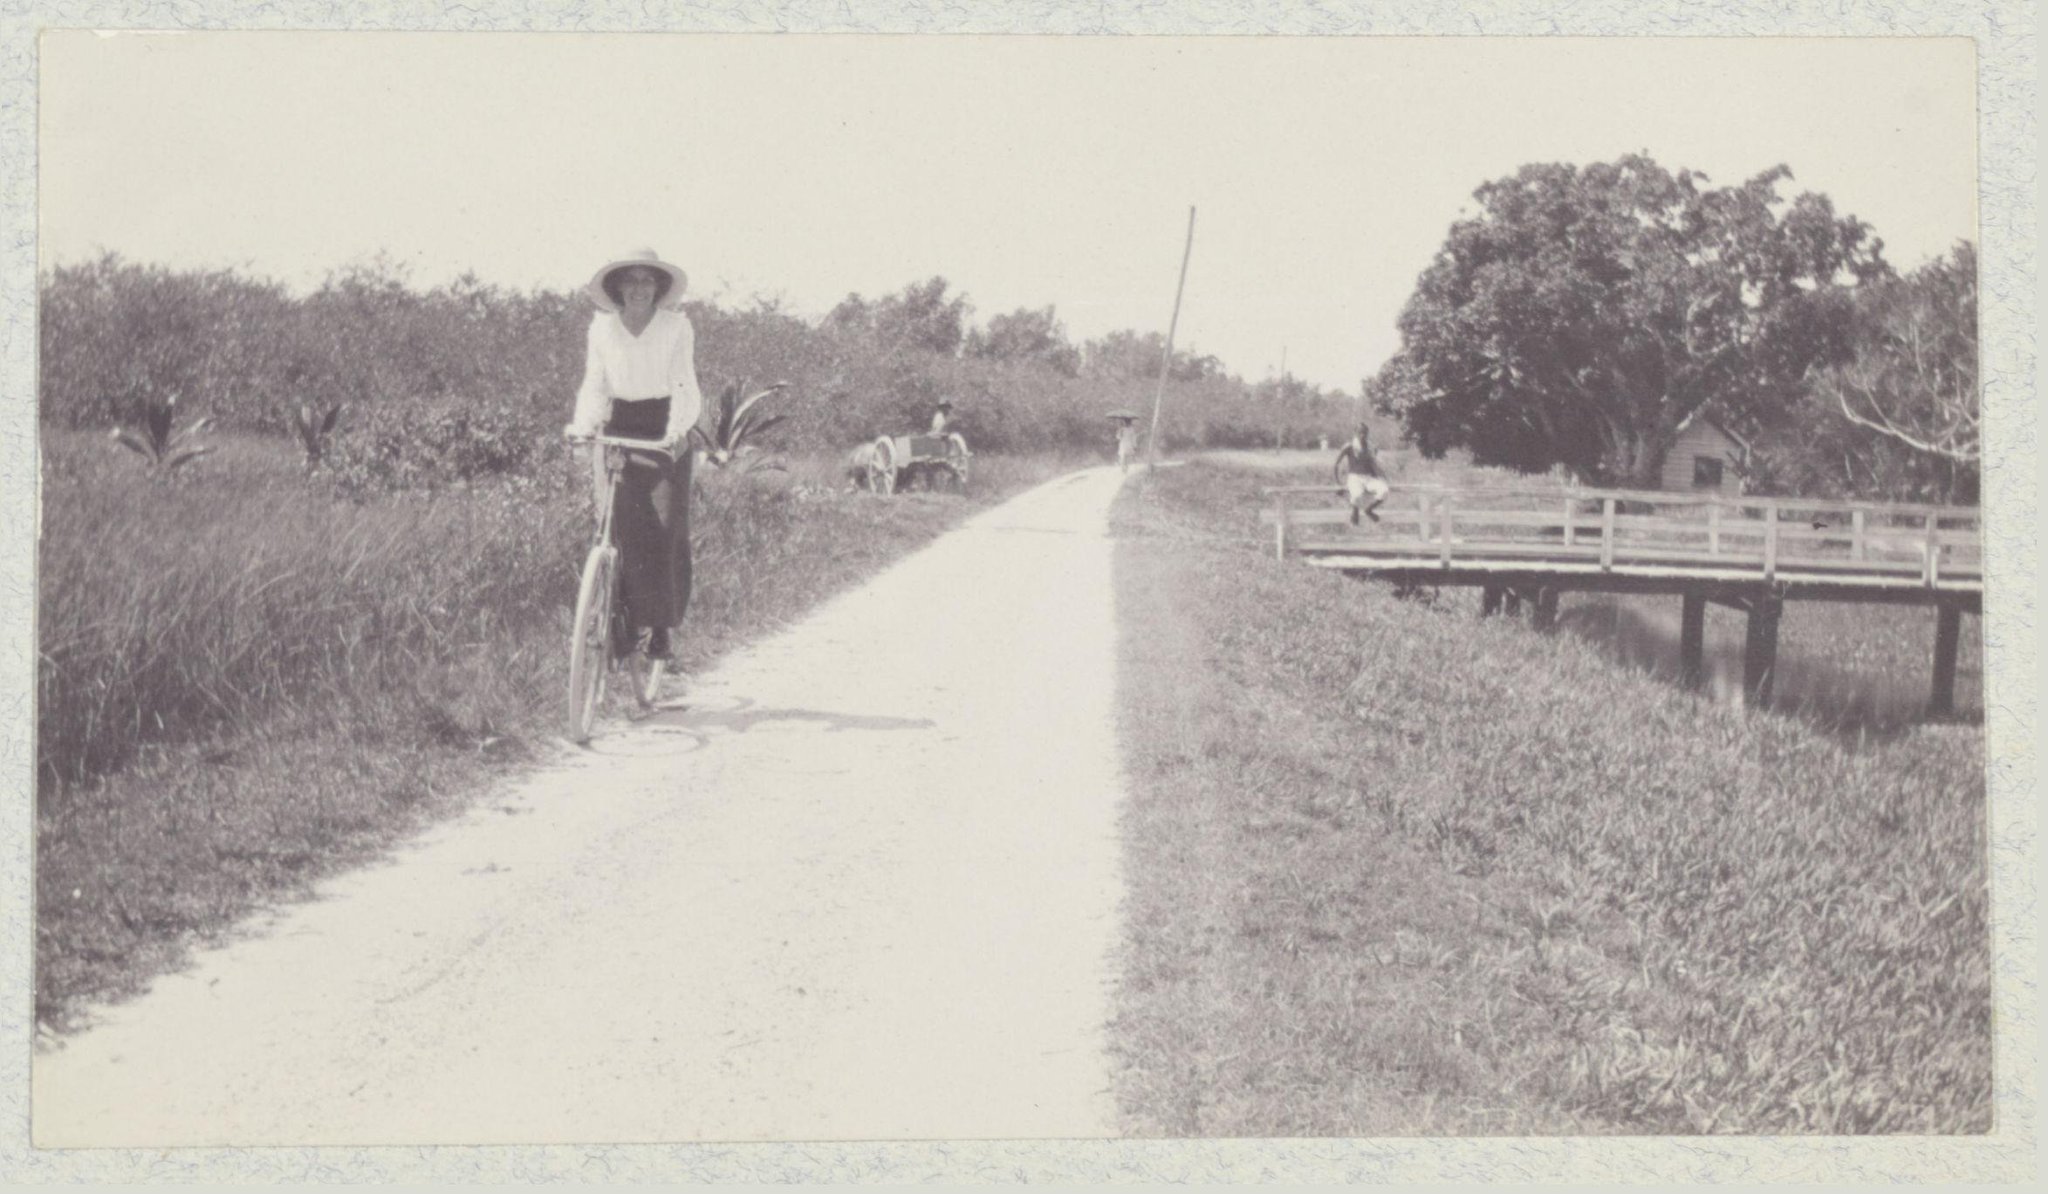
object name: photograph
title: Maria Gonggrijp op de fiets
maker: andries augustus boom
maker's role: amateurfotograaf, handelaar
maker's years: 1878-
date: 1911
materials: photographic support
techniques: photography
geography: suriname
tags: bicycle, suriname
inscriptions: inscription: ‘"morgenstond"’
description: Maria Gonggrijp op de fiets bij Plantage Morgenstond, 1911. Onderdeel van het fotoalbum van de familie Boom-Gonggrijp in Suriname en Curaçao.